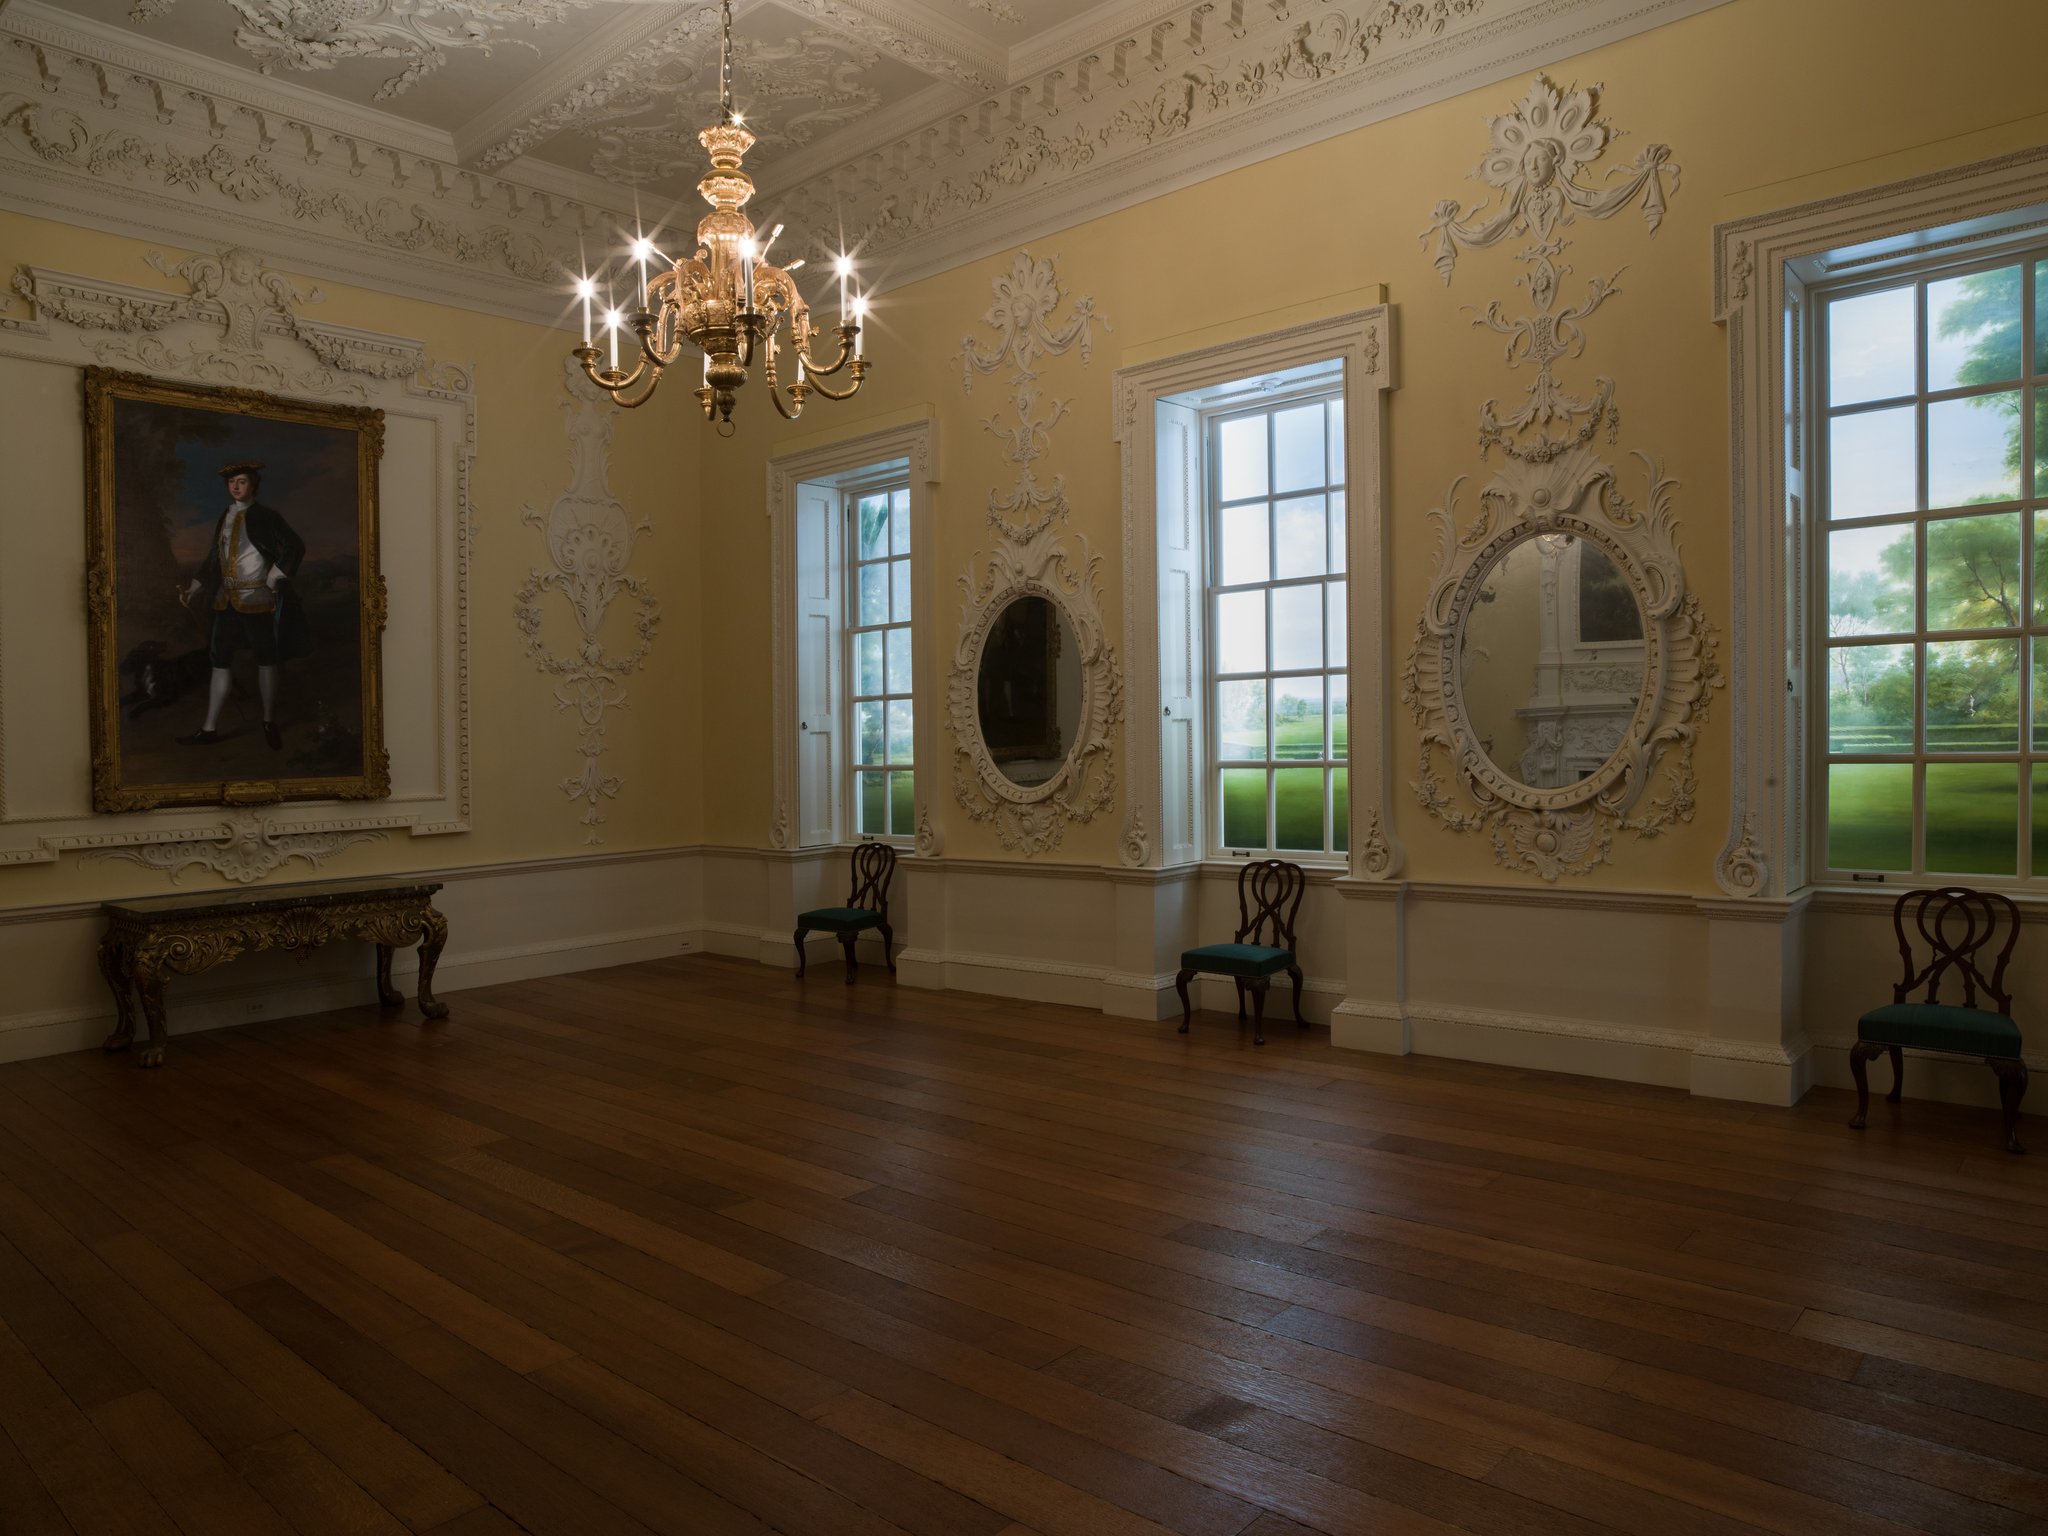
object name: period room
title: Dining room from Kirtlington Park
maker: john sanderson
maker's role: designer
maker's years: 1730-1774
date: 1748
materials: marble, plaster, wood